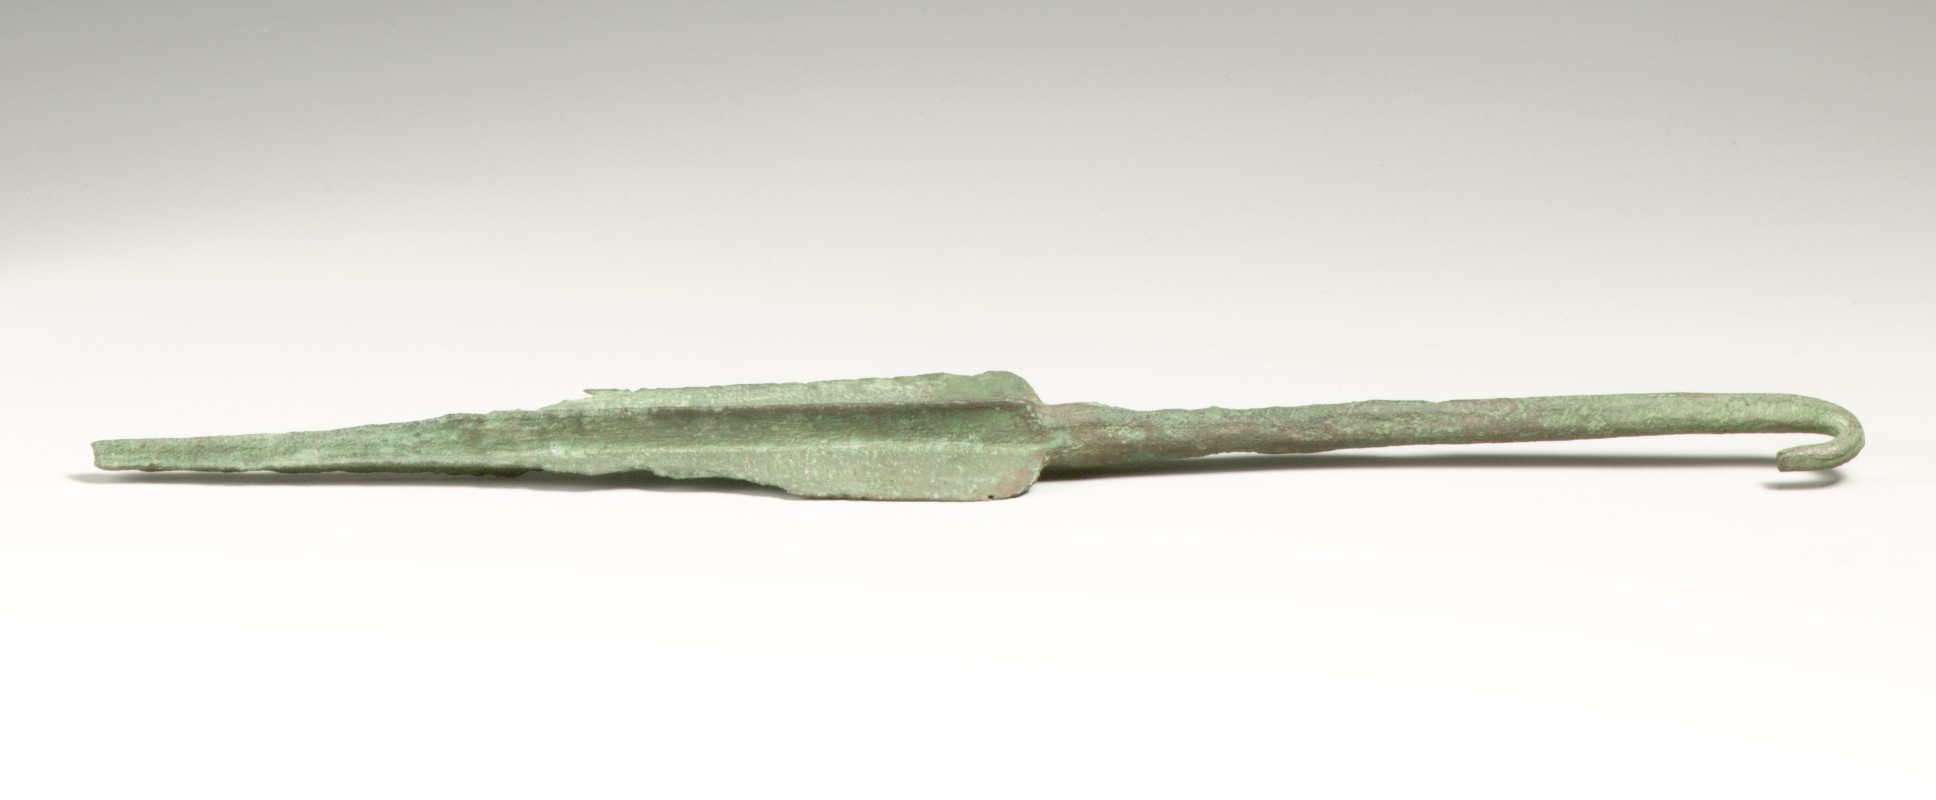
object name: dagger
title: Copper alloy spearhead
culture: cypriot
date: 2500-2000 BCE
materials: bronze